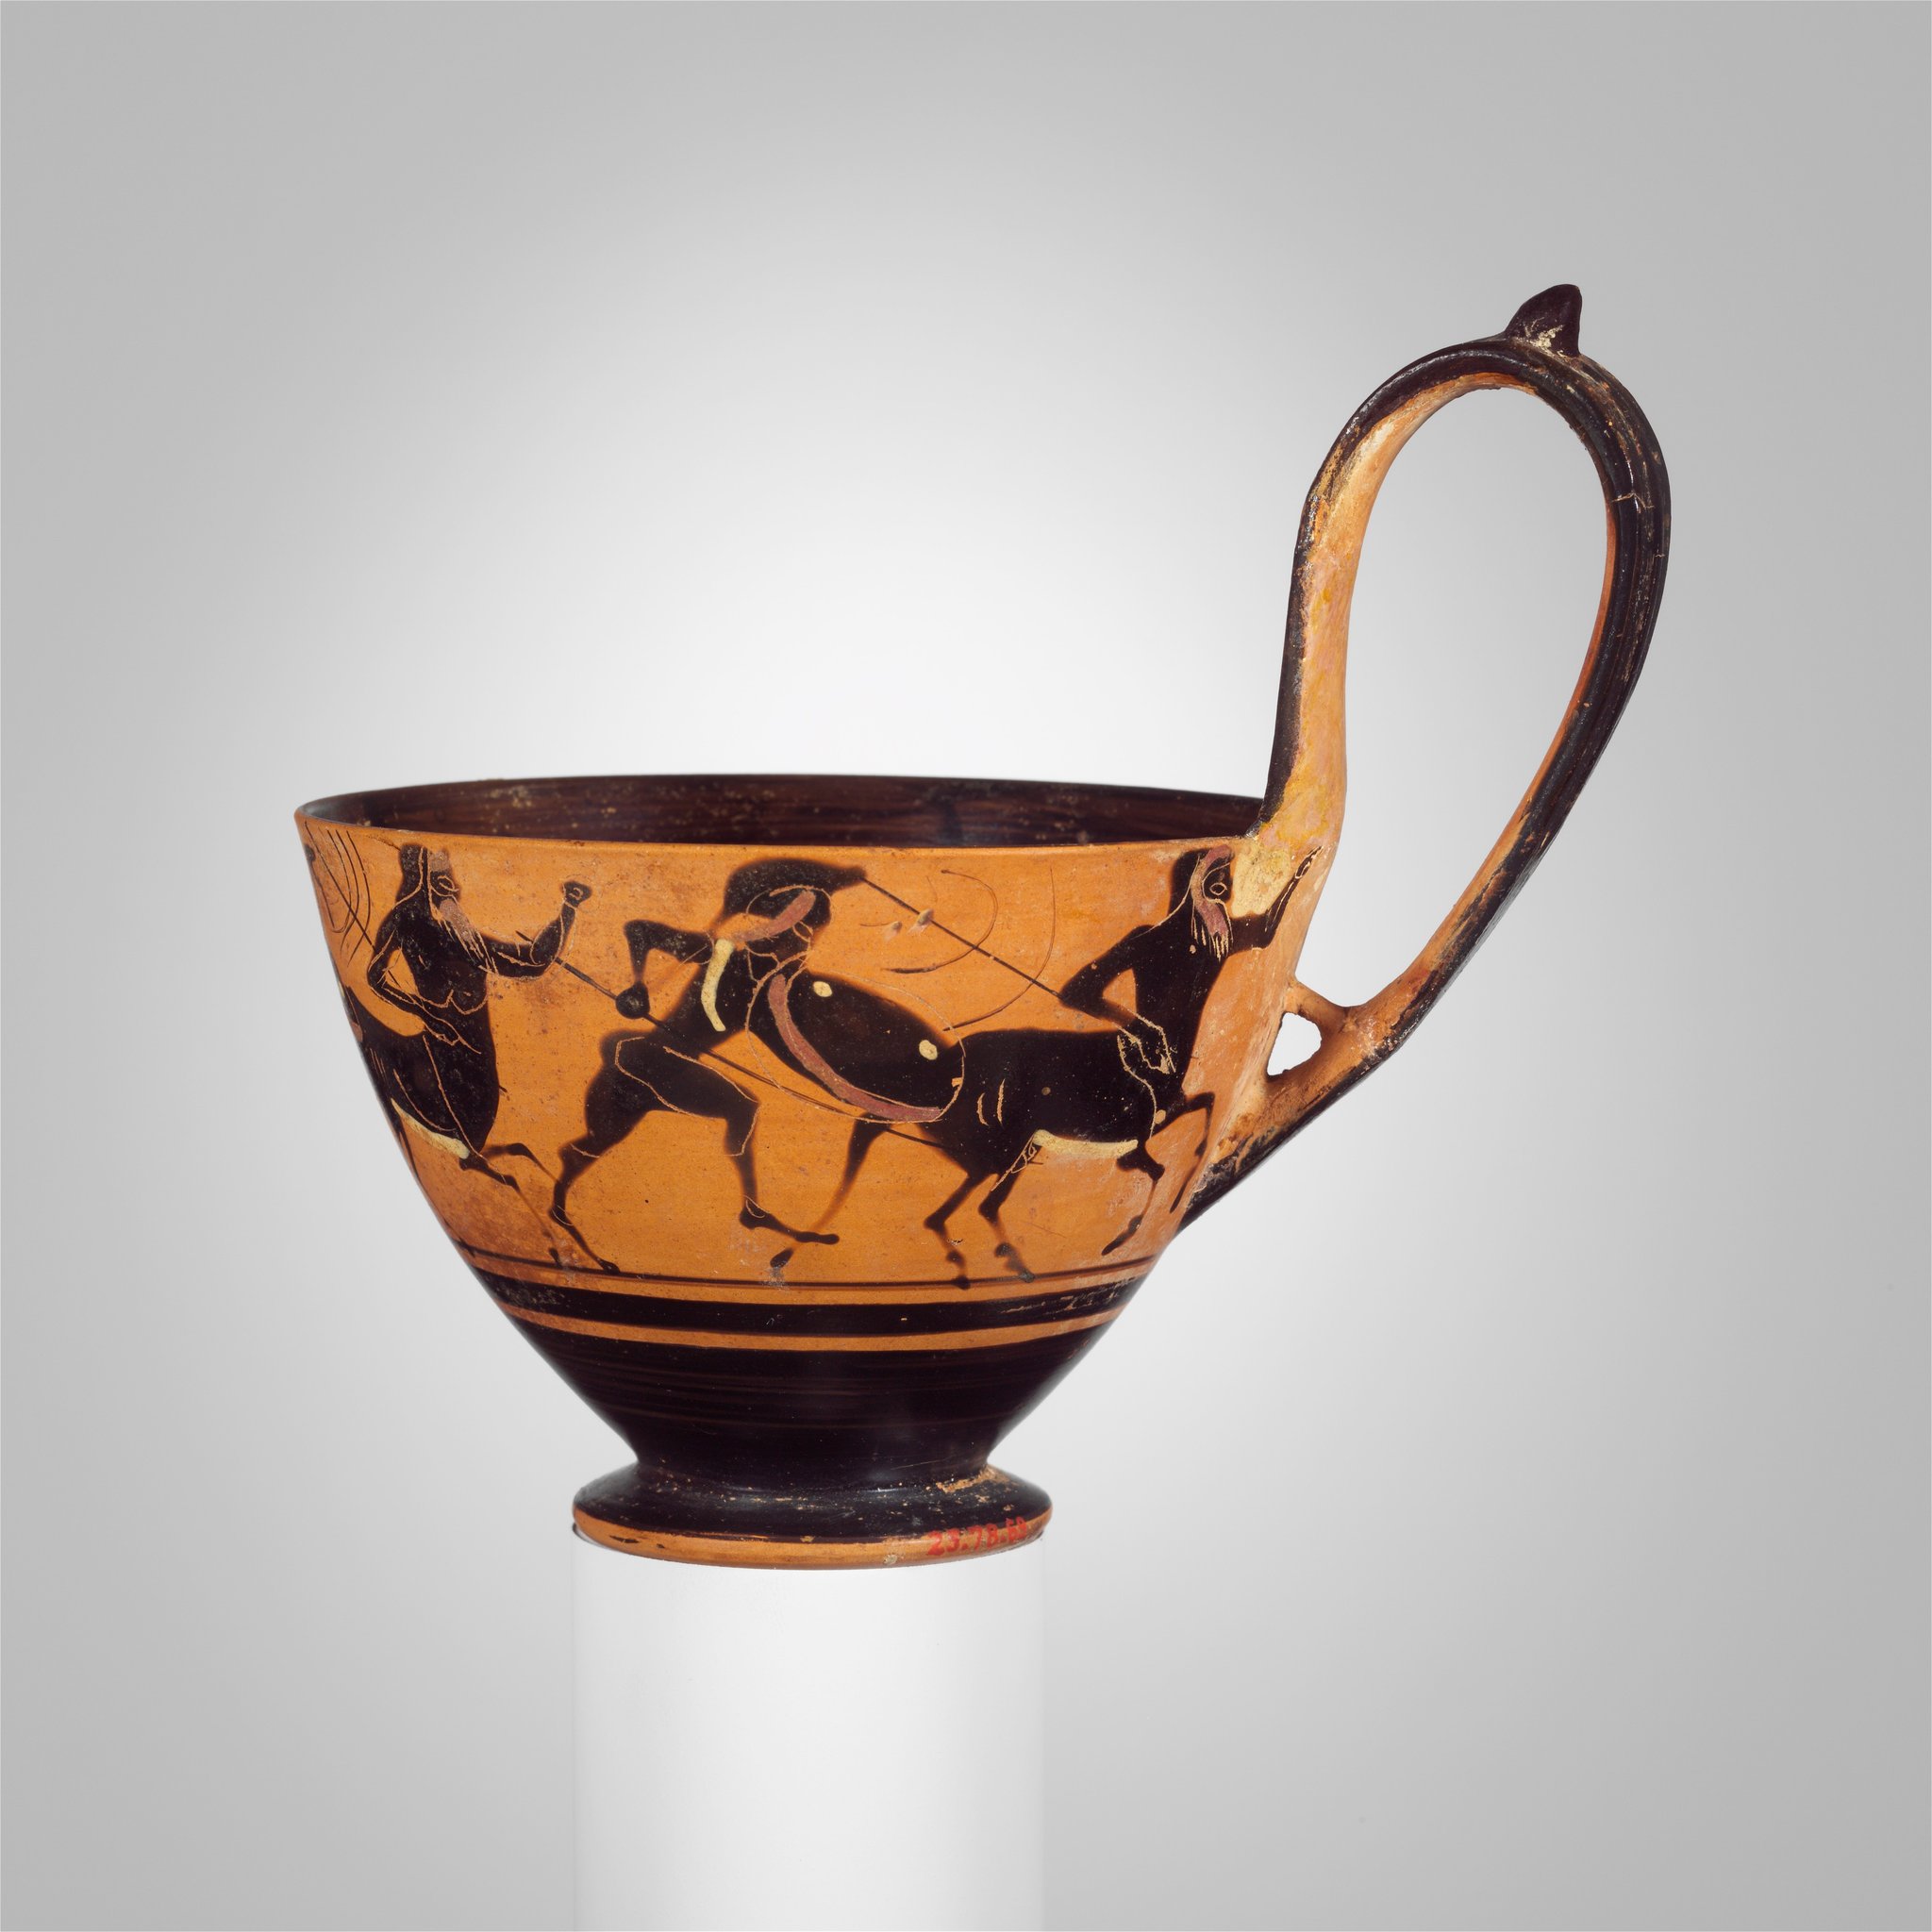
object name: kyathos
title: Terracotta kyathos (cup-shaped ladle)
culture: greek, attic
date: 530-500 BCE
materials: terracotta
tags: shields,men,centaurs